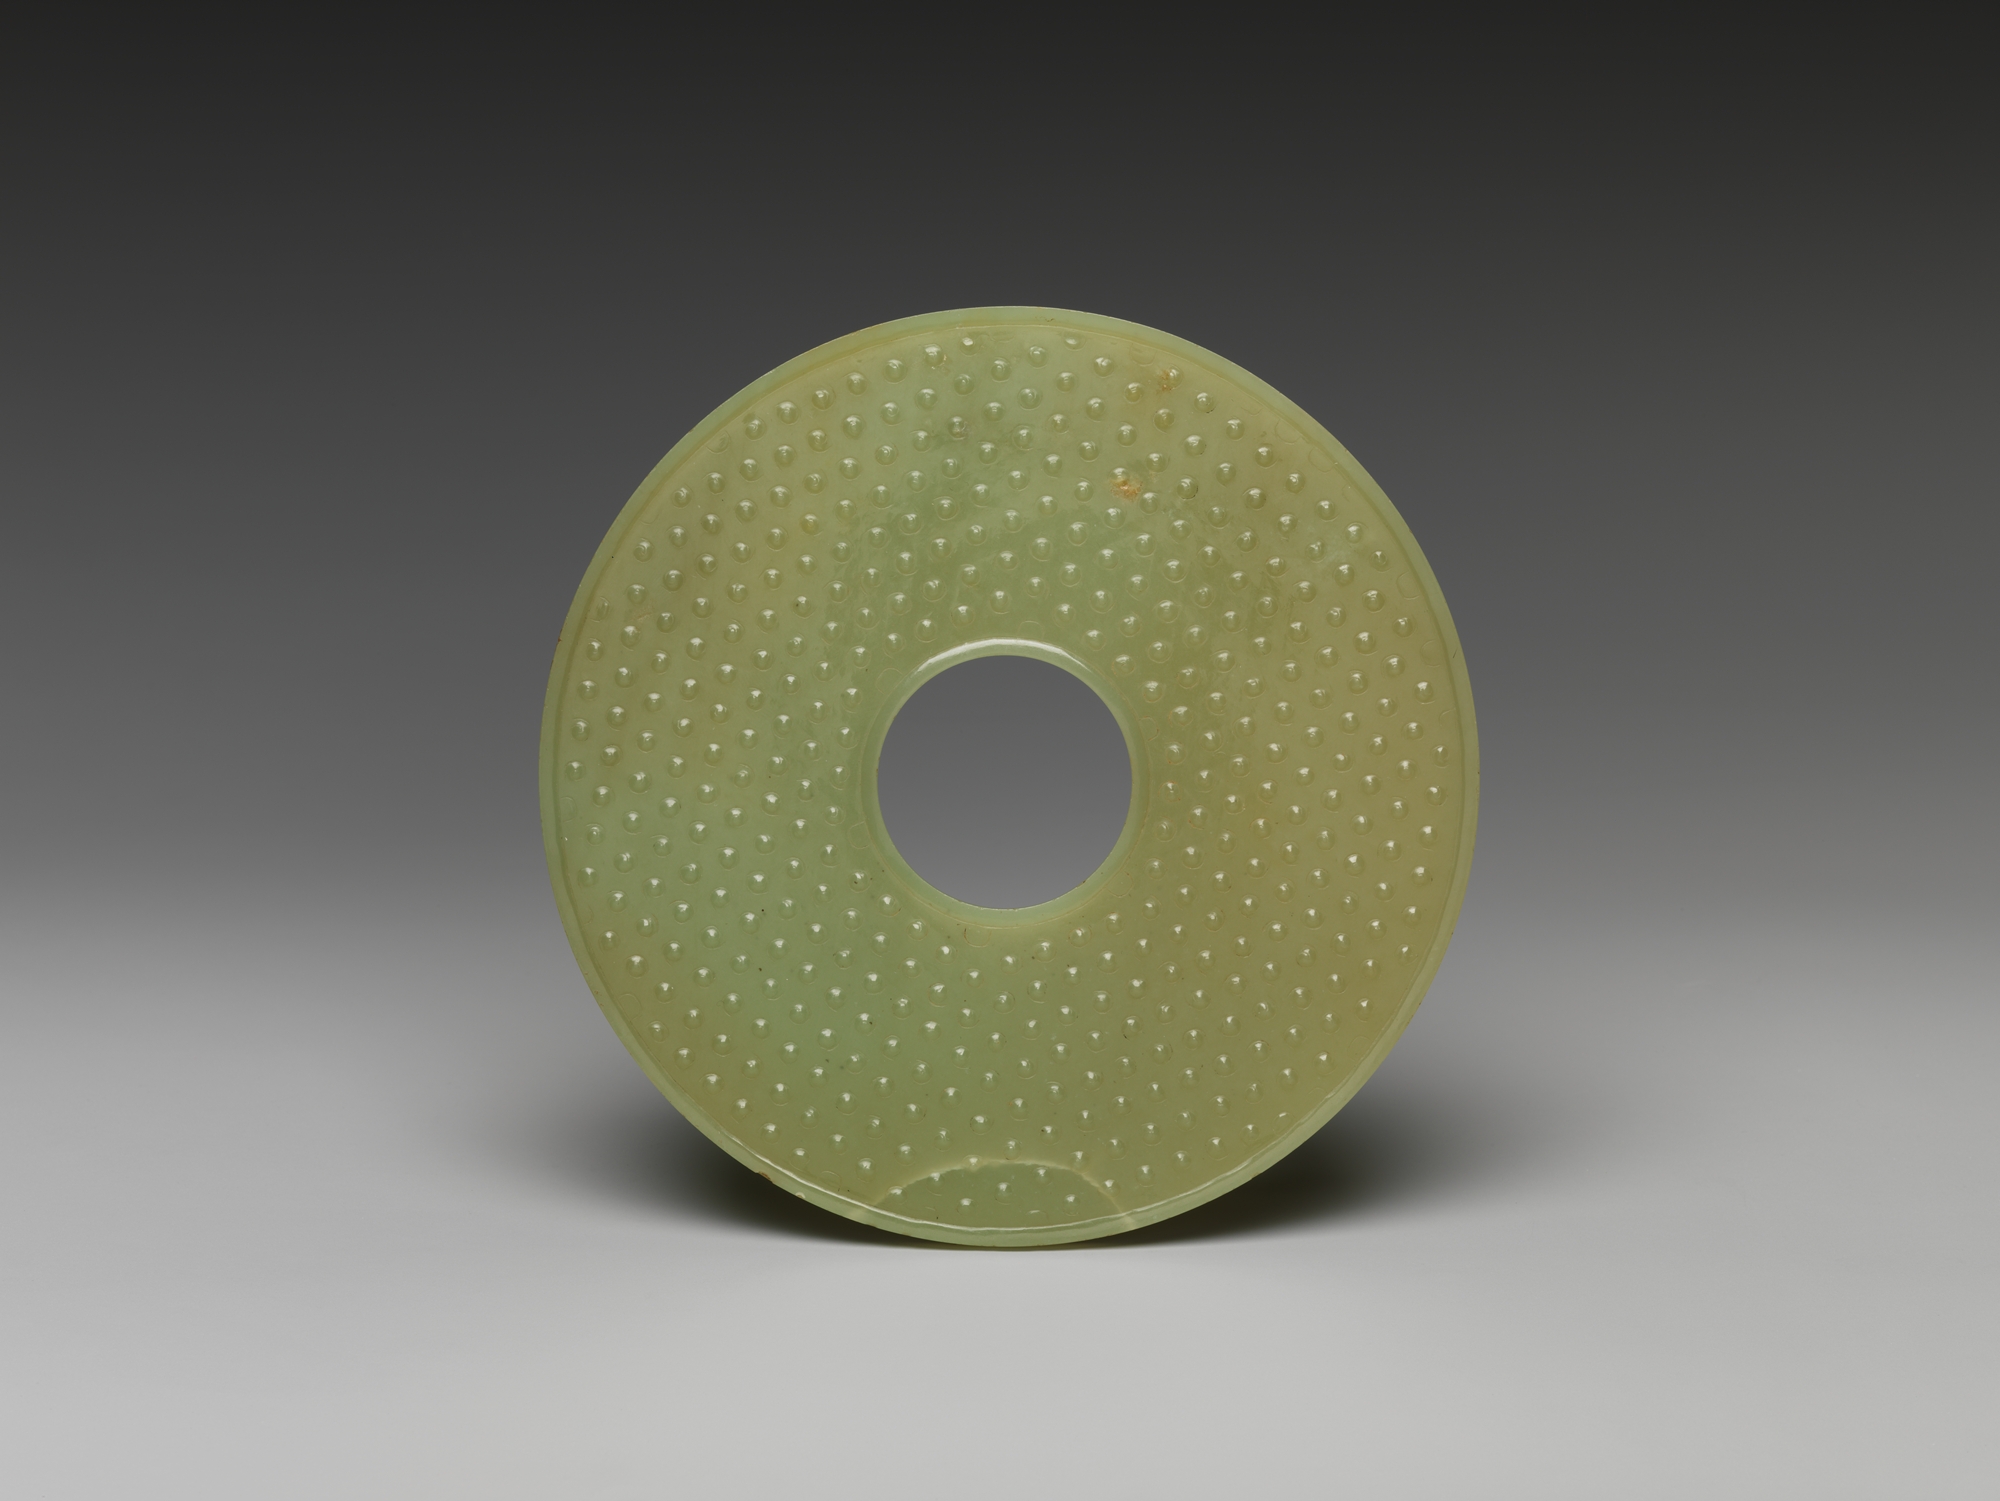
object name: disc bi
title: Disc (Bi)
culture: chinese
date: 300-101 BCE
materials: jade